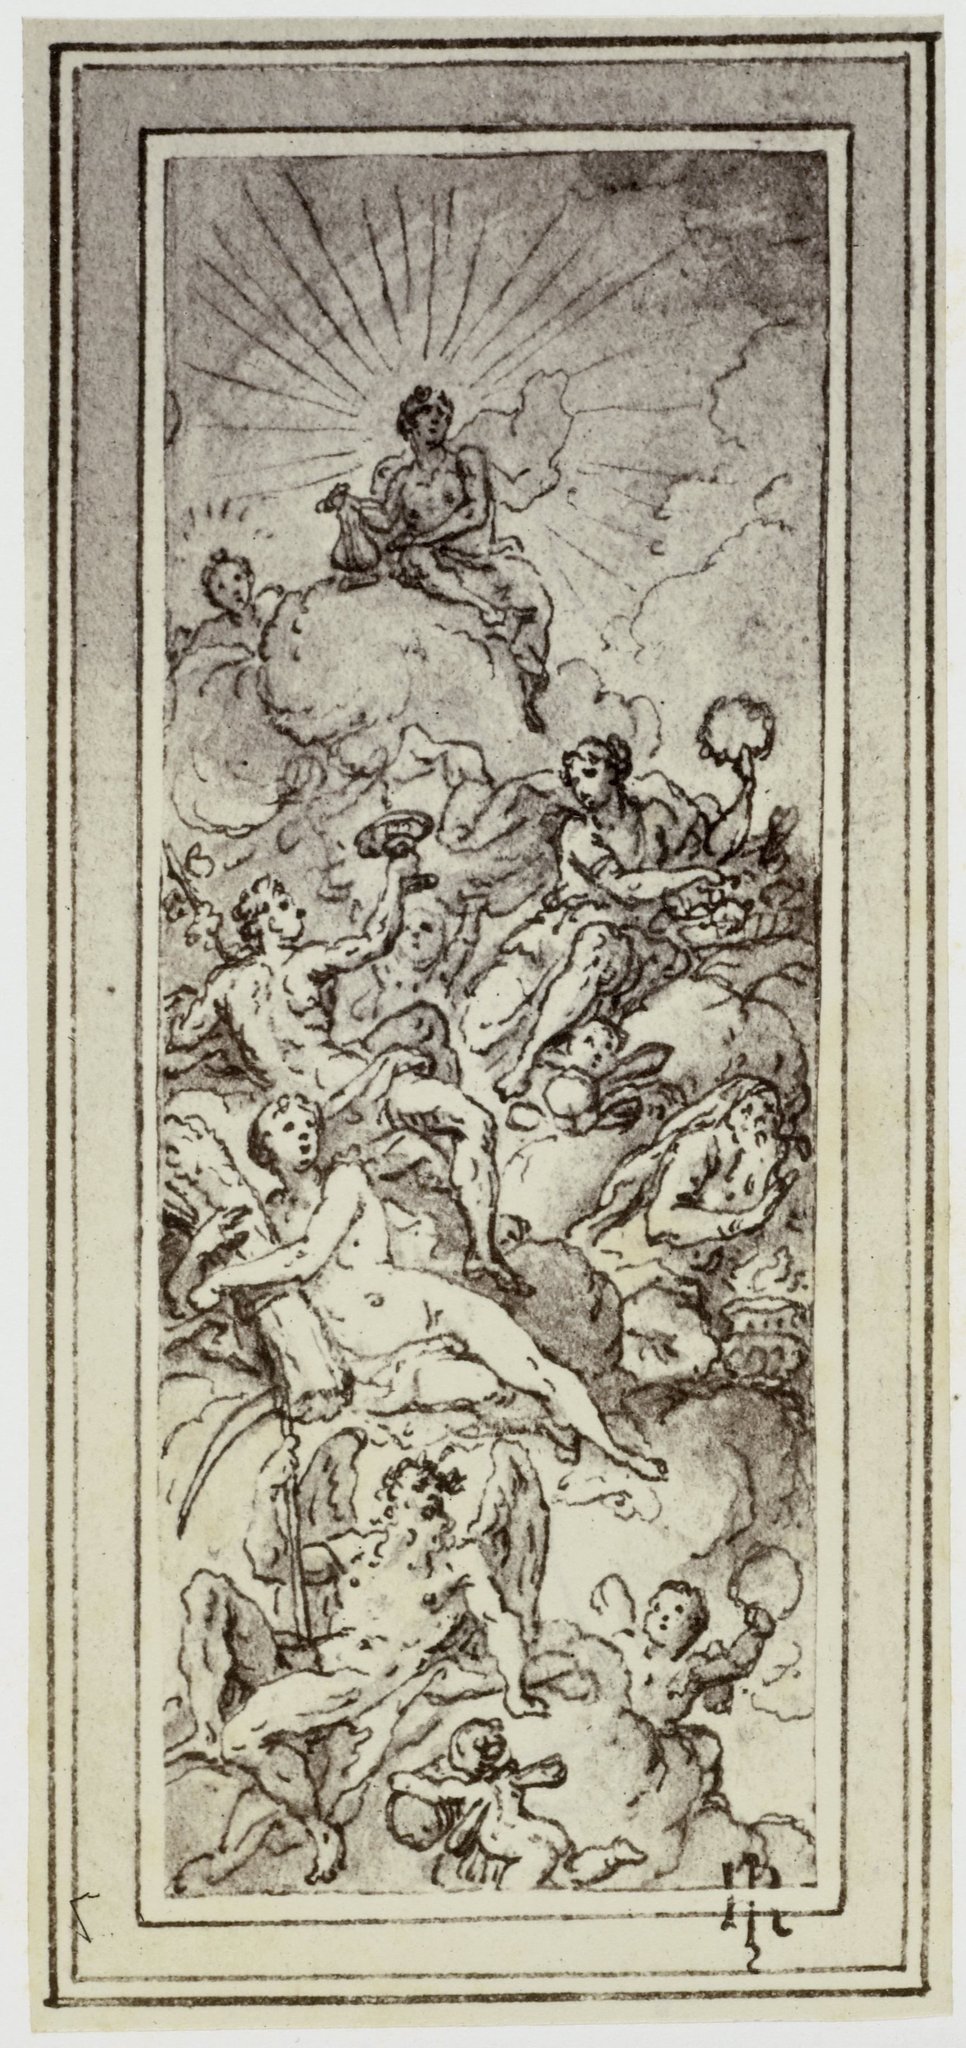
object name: photograph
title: Sir J. Thornhill, The Ceiling of Greenwich Hospital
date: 1855-1858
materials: cardboard, paper, photographic support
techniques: albumen print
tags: drawing, sketch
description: Fotoreproductie van tekening in 'The Reveley Collection of Drawings at Brynygwin', afb. 59.